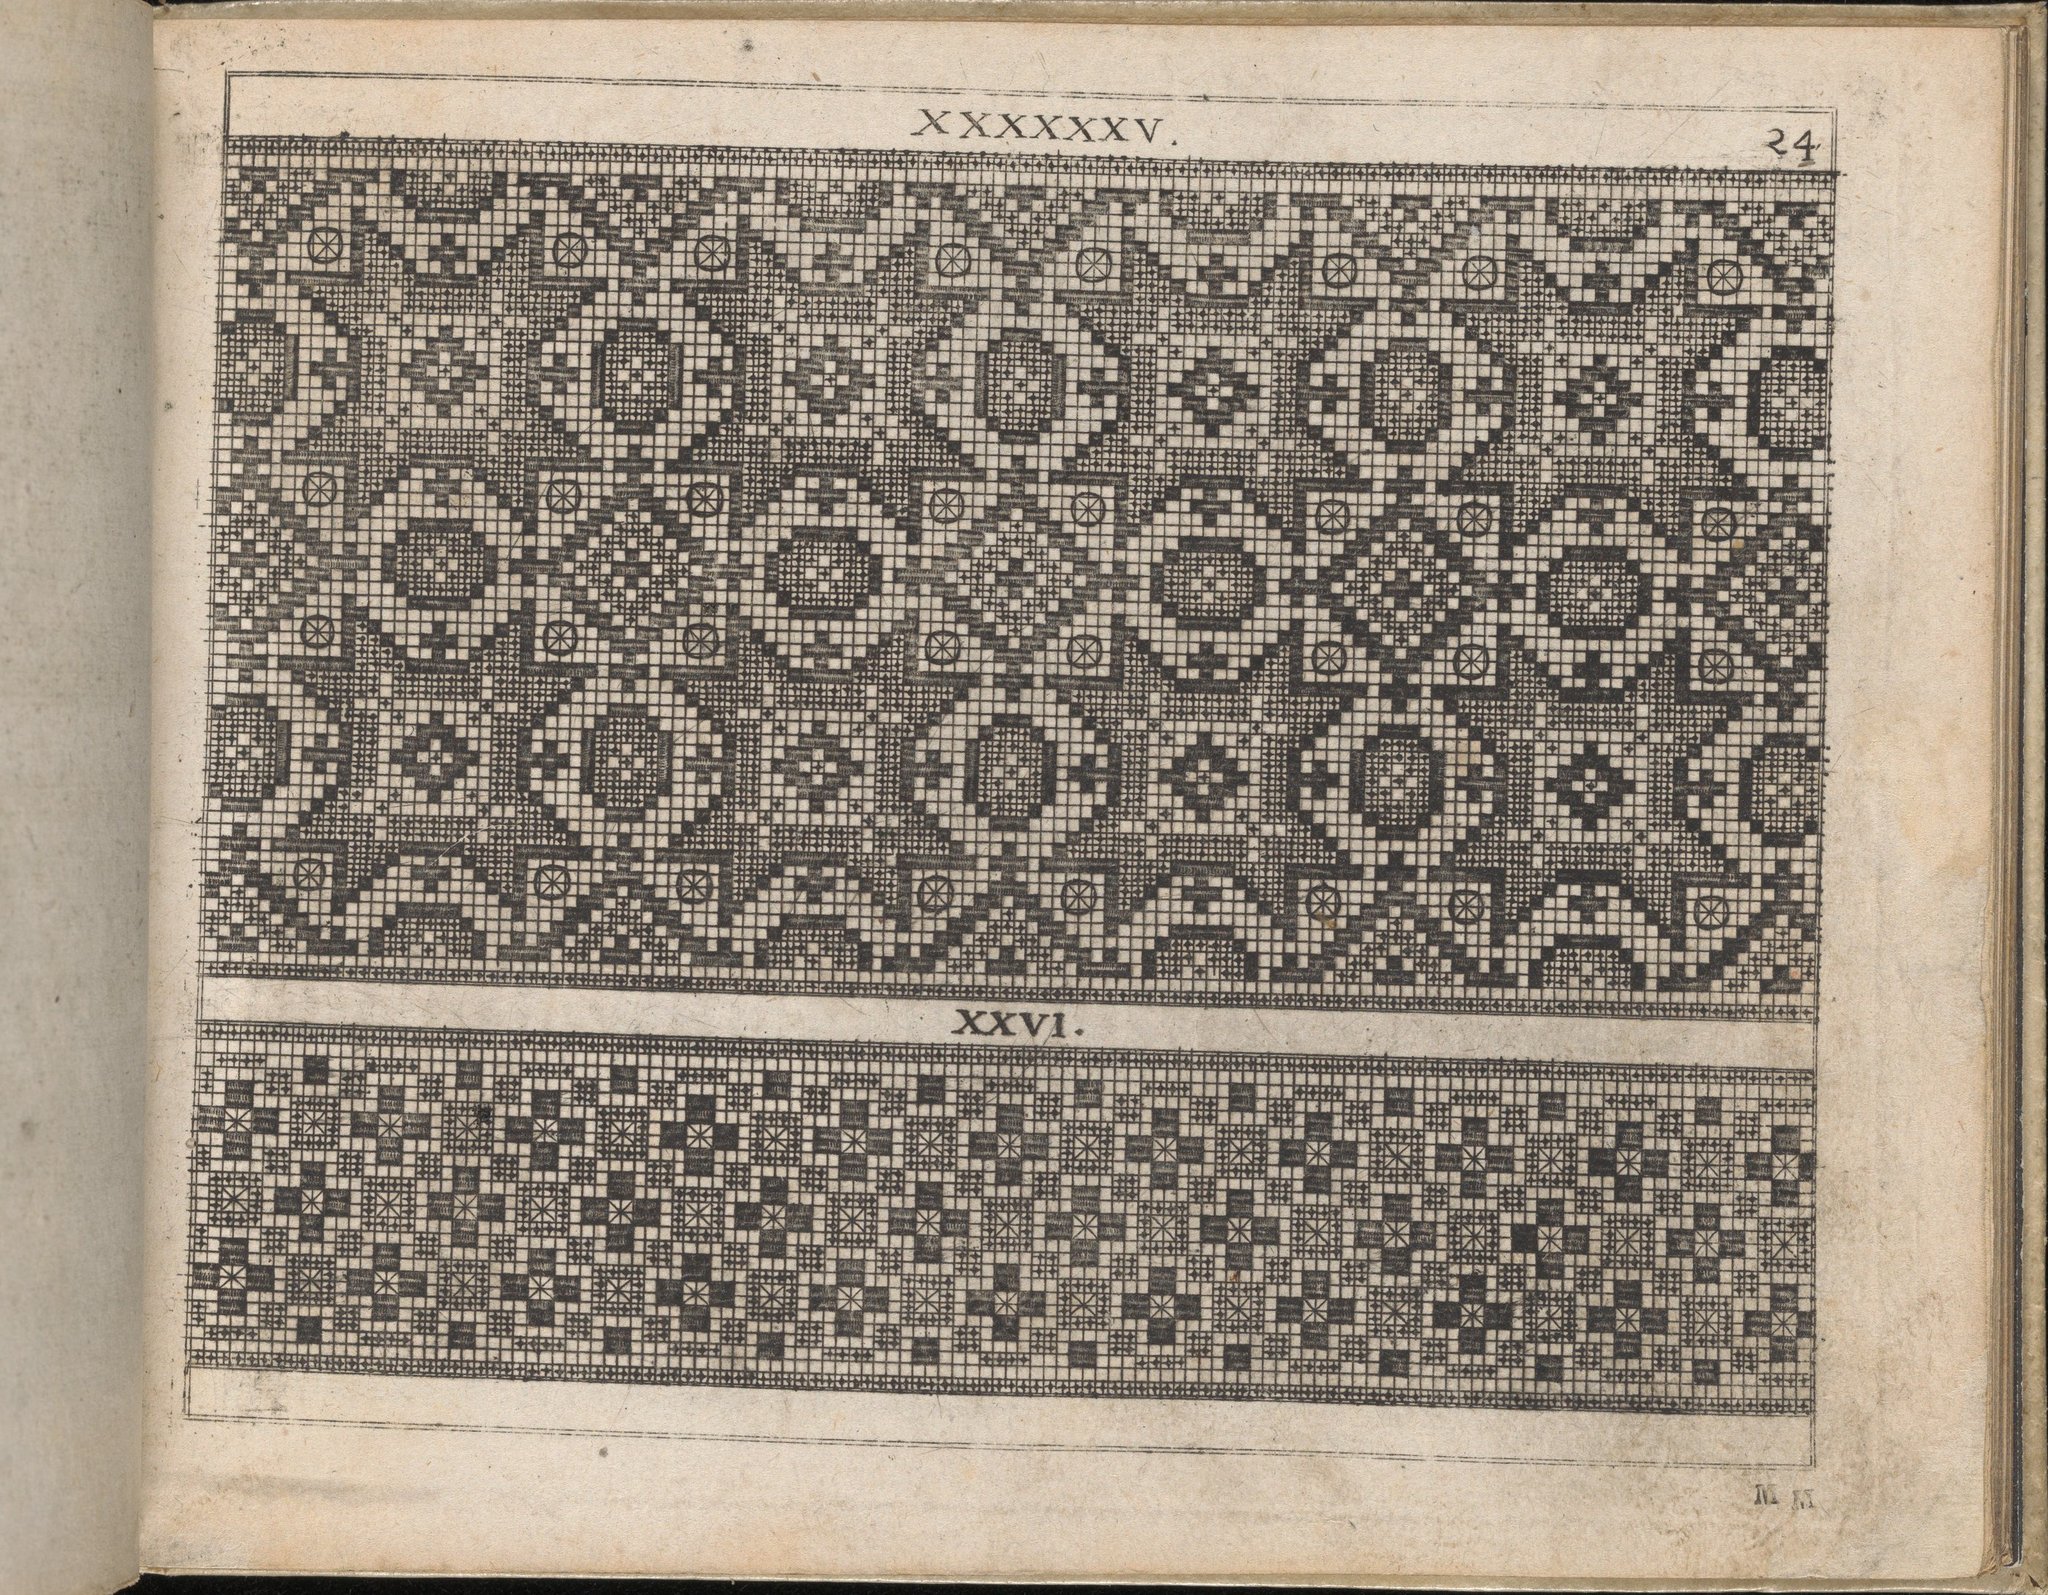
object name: book print ornament architecture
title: Newes Modelbuch in Kupffer (Page 33r)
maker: johann sibmacher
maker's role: artist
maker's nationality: german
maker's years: 1590-1611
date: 1604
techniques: etching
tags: ornament